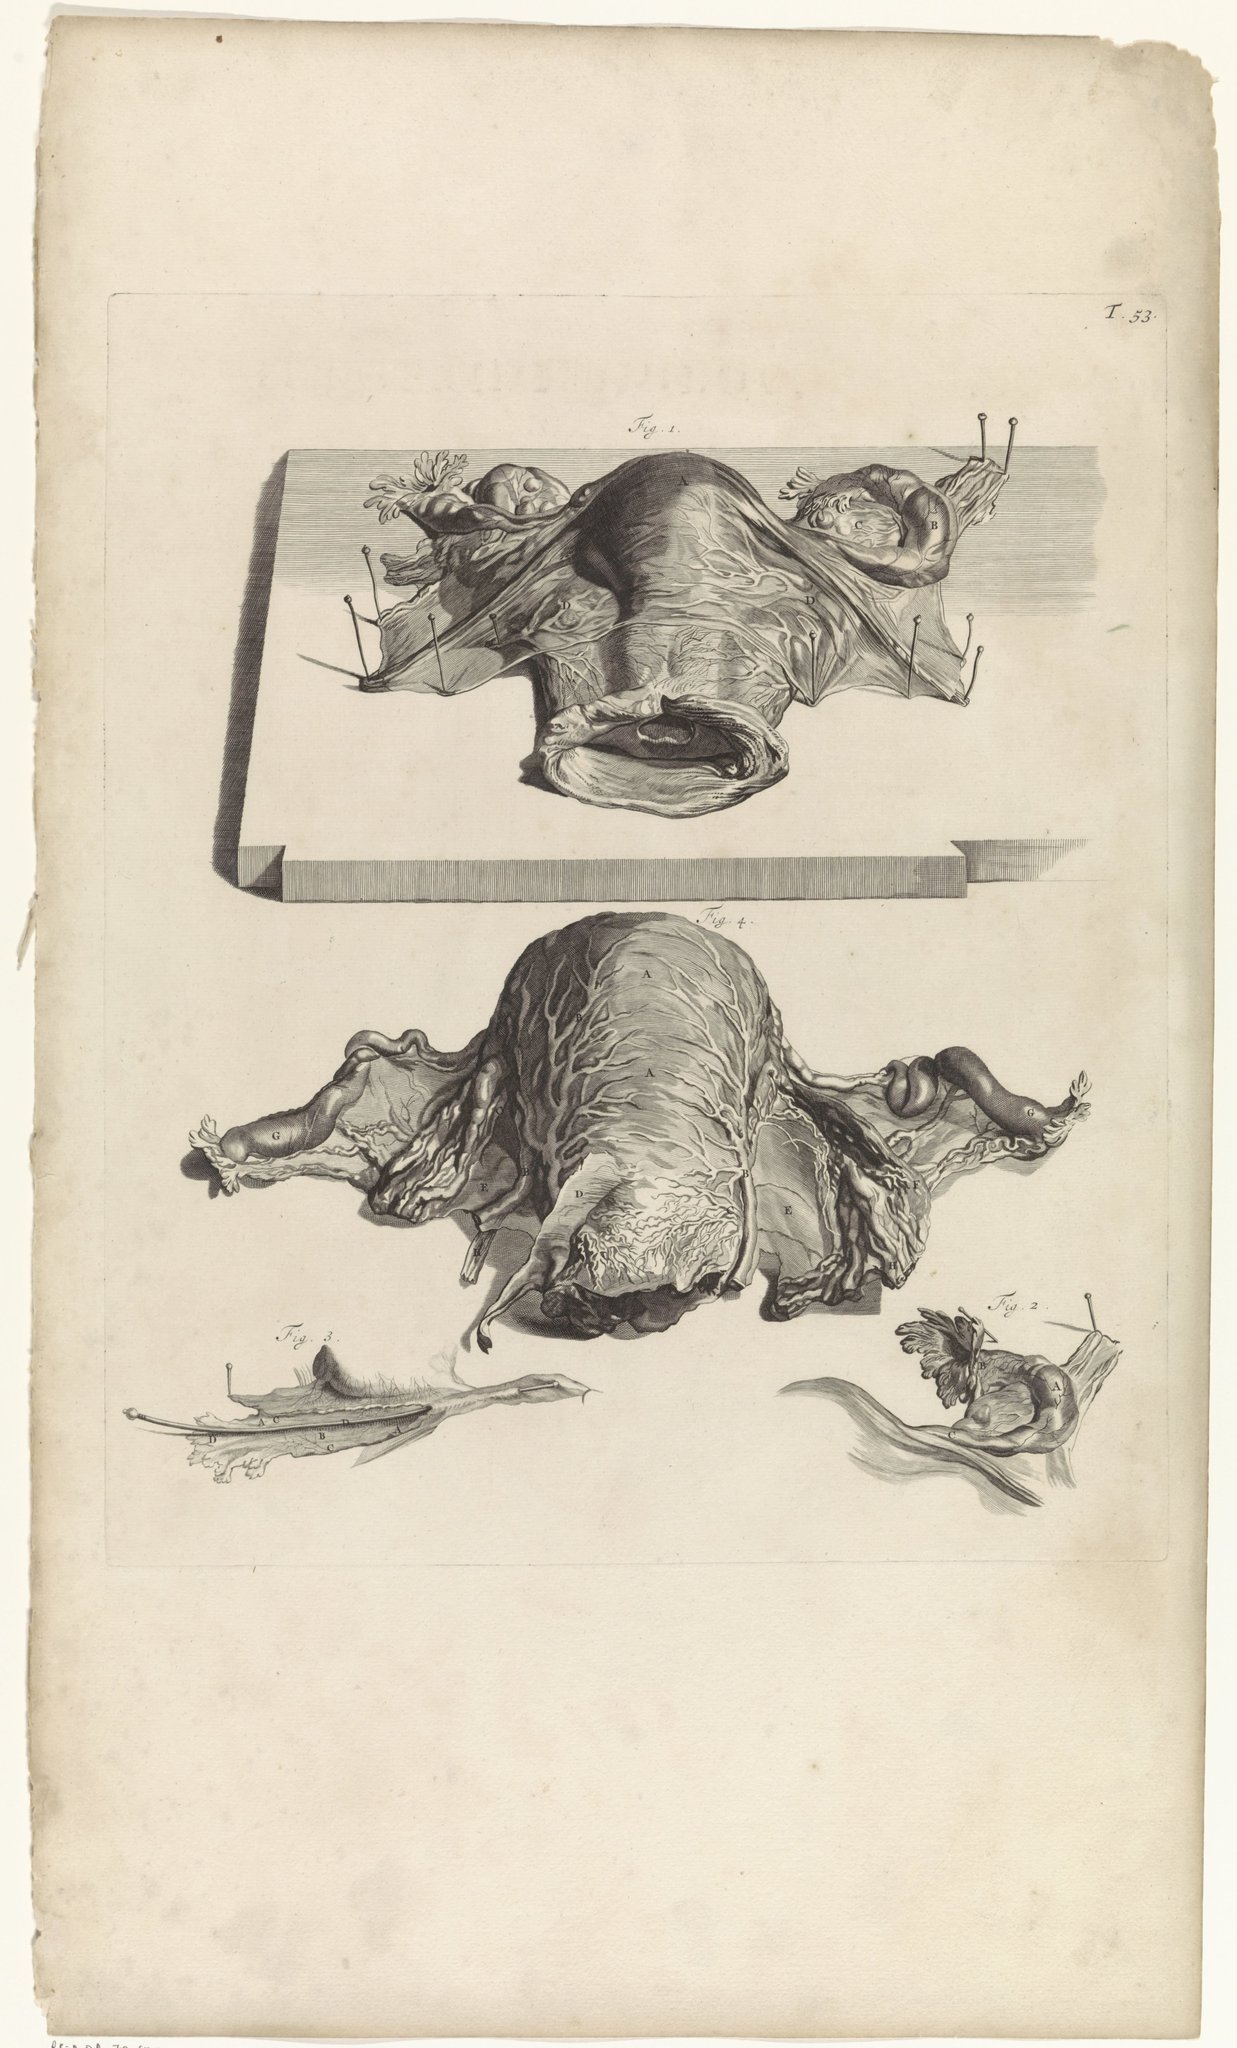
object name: print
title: Anatomische studie van de baarmoeder en de eierstokken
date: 1685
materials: paper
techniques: engraving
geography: amsterdam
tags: womb, uterus, ovaries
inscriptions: collector's mark: Lugt 2228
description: Boekillustratie voor Bidloo, Godefridus. Anatomia humani corporis centum & quinque tabulis, per art. G. de Lairesse ad vivum delineatis, de monstrata, veterum recentiorumque inventis explicata plurimisque, hactenus non detectis, illustrata. Amsterdam: Weduwe Joannes van Someren, Hendrick Boom en erven Dirk Boom, 1685.